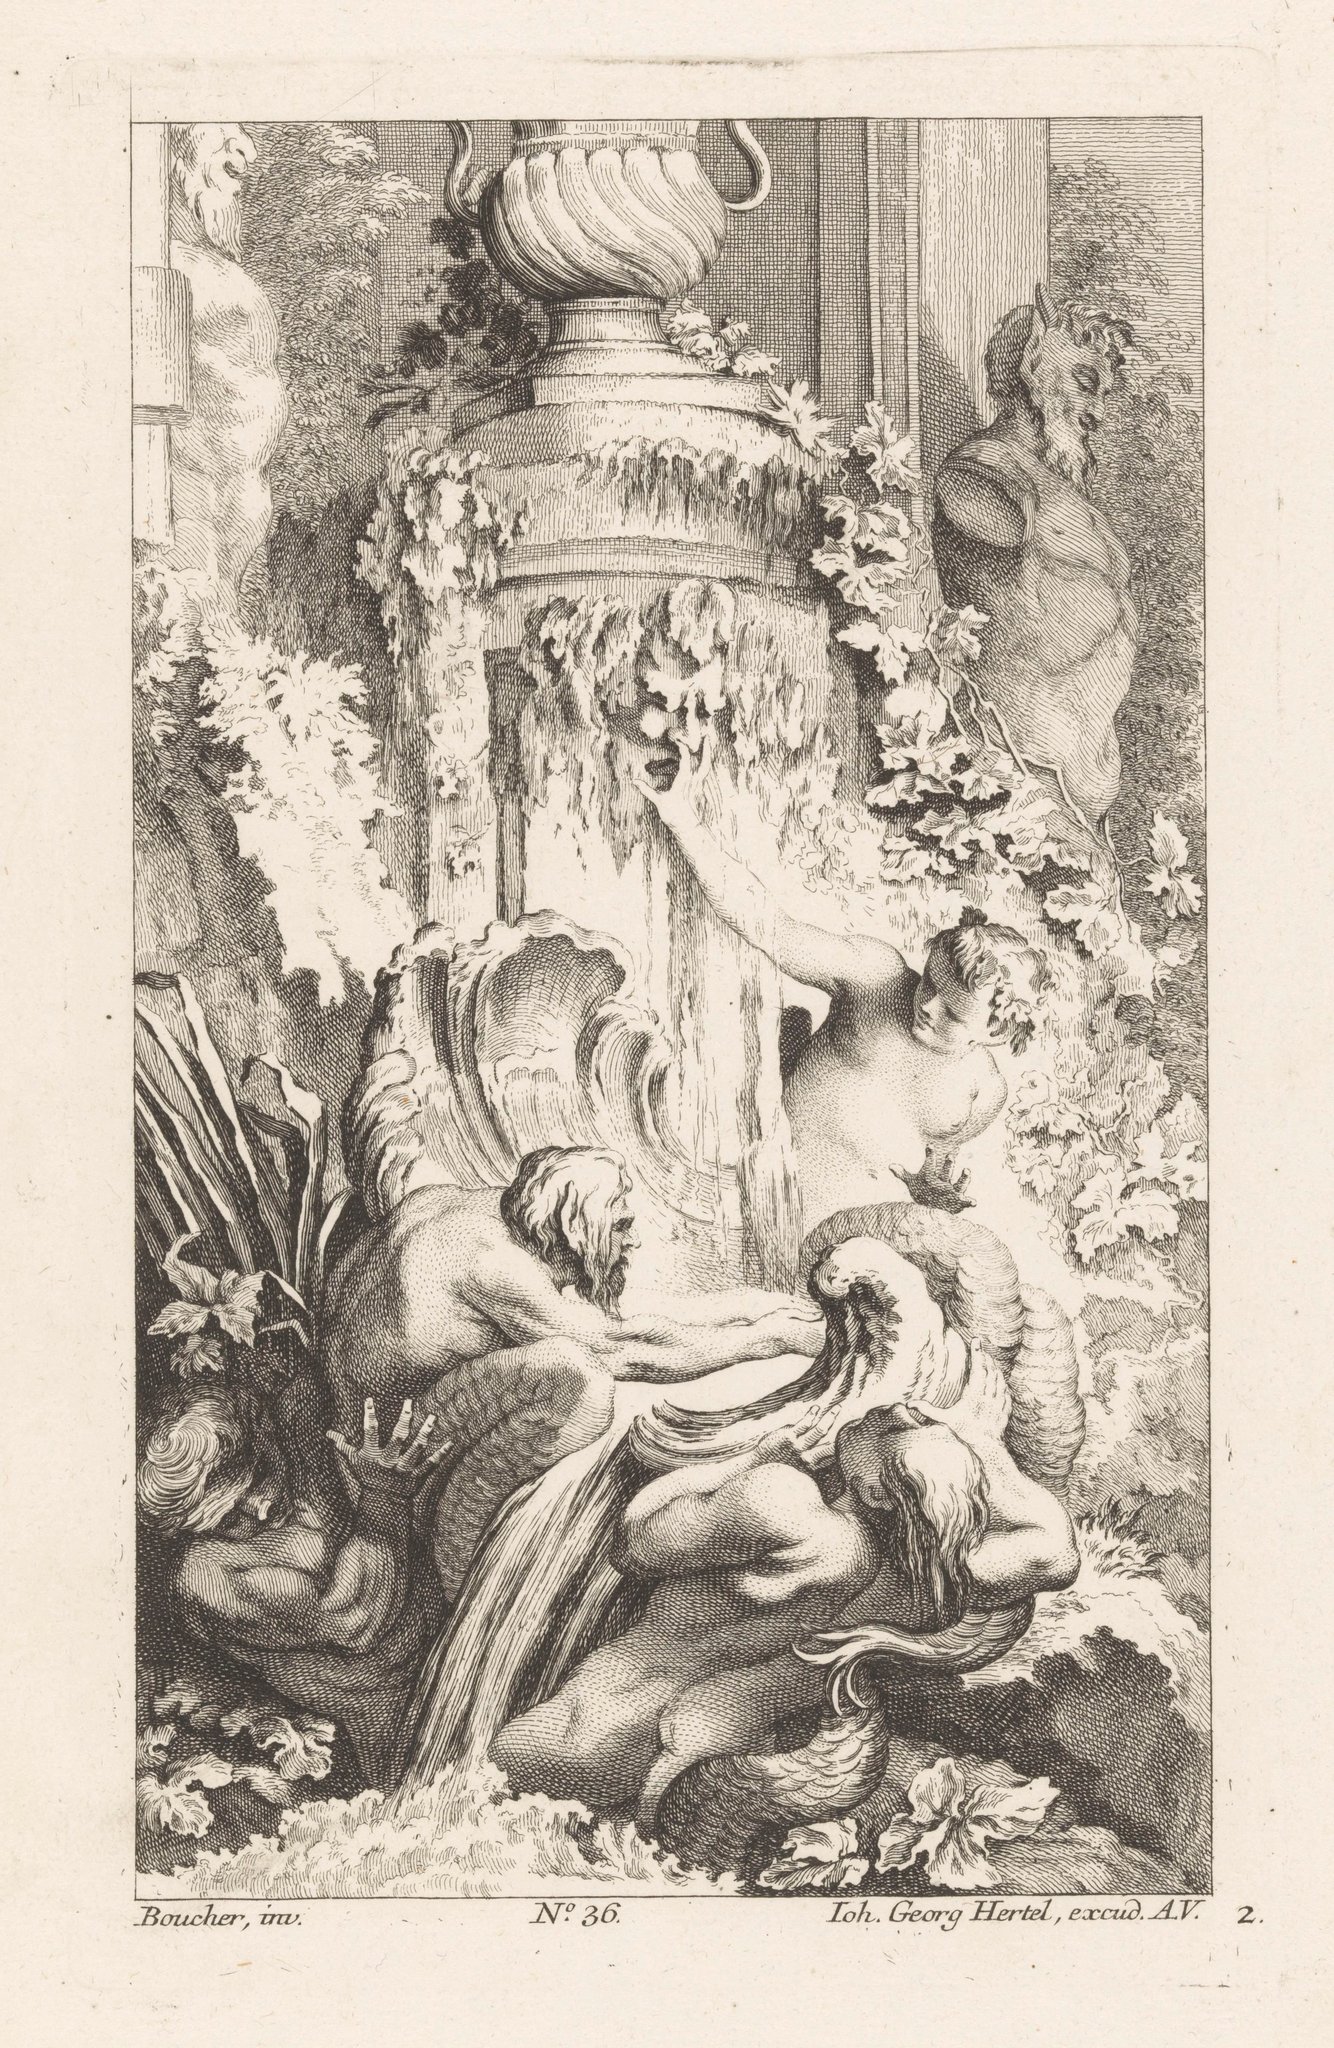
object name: ornament print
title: Fontein met meermannen en saterbeeld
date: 1713-1760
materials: paper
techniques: etching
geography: augsburg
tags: merman, vase ~ ornament, satyr(s) (in general), ornamental fountain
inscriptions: collector's mark: Lugt 2228, collector's mark: Lugt 2760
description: Drie meermannen zitten links van een schelpvormige fontein, rechts houdt een jonge figuur de rechterhand tegen een waterstraal. Twee saterbeelden flankeren een vaas boven de fontein. Uitgeversnummer 36.